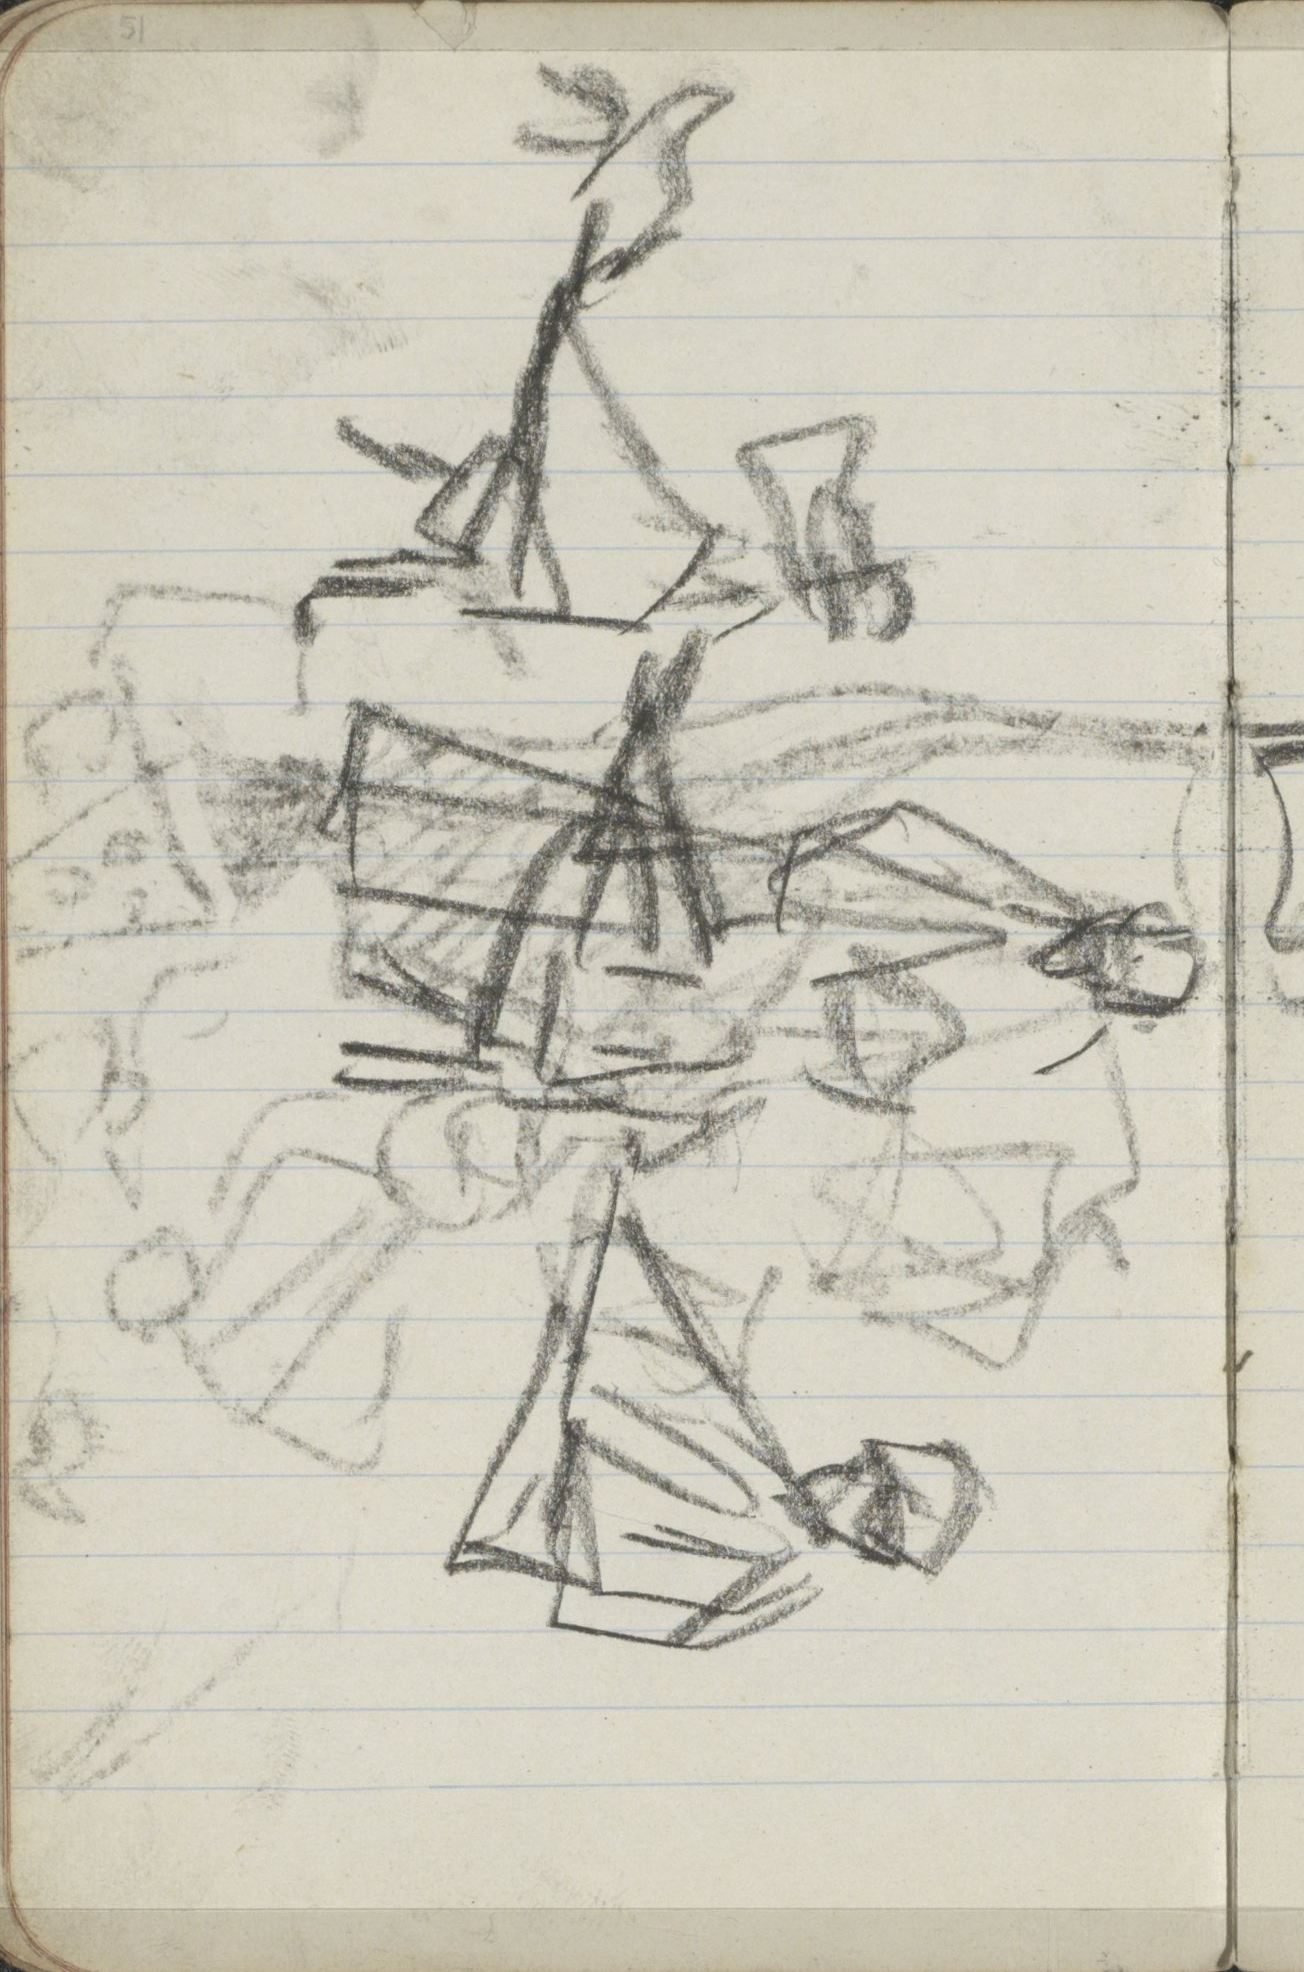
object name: sketchbook leaf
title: Figuren op Hartjesdag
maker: george hendrik breitner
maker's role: draughtsman, painter, print maker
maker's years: 1857-1923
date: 1808-1894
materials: chalk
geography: amsterdam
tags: adult woman, child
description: Pagina 51 uit een schetsboek met 31 bladen.